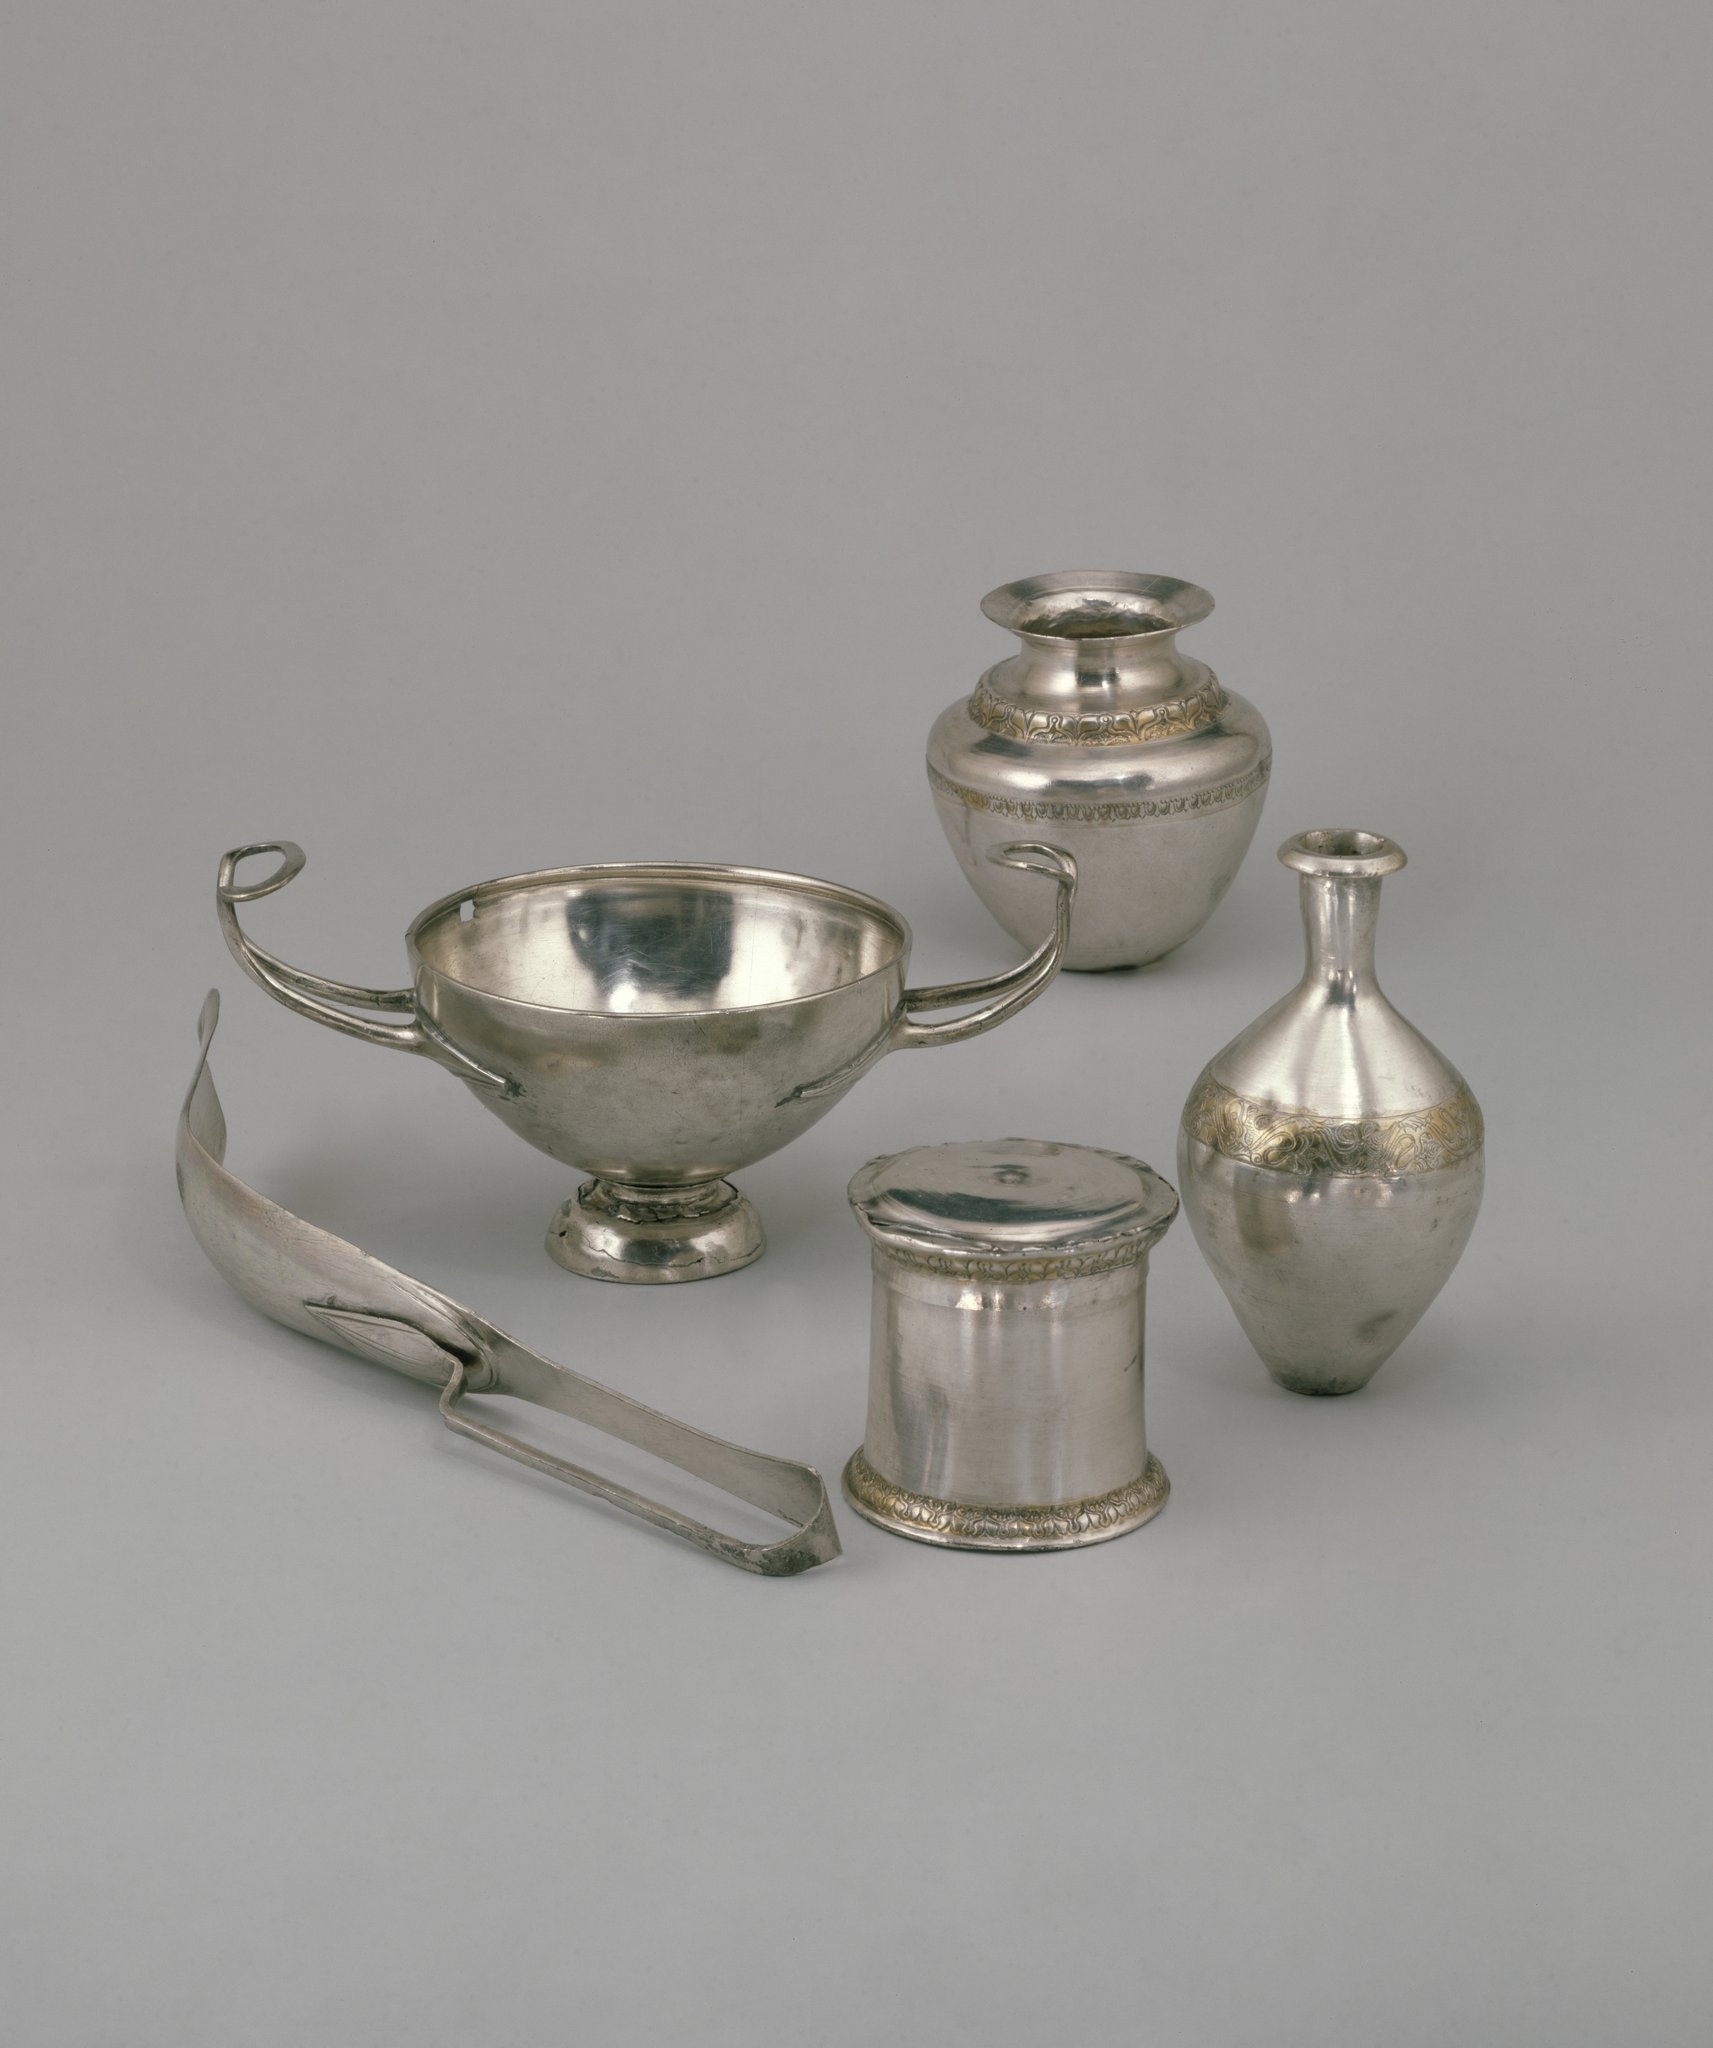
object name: kylix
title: Silver kylix (drinking cup)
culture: greek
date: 334-235 BCE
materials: silver